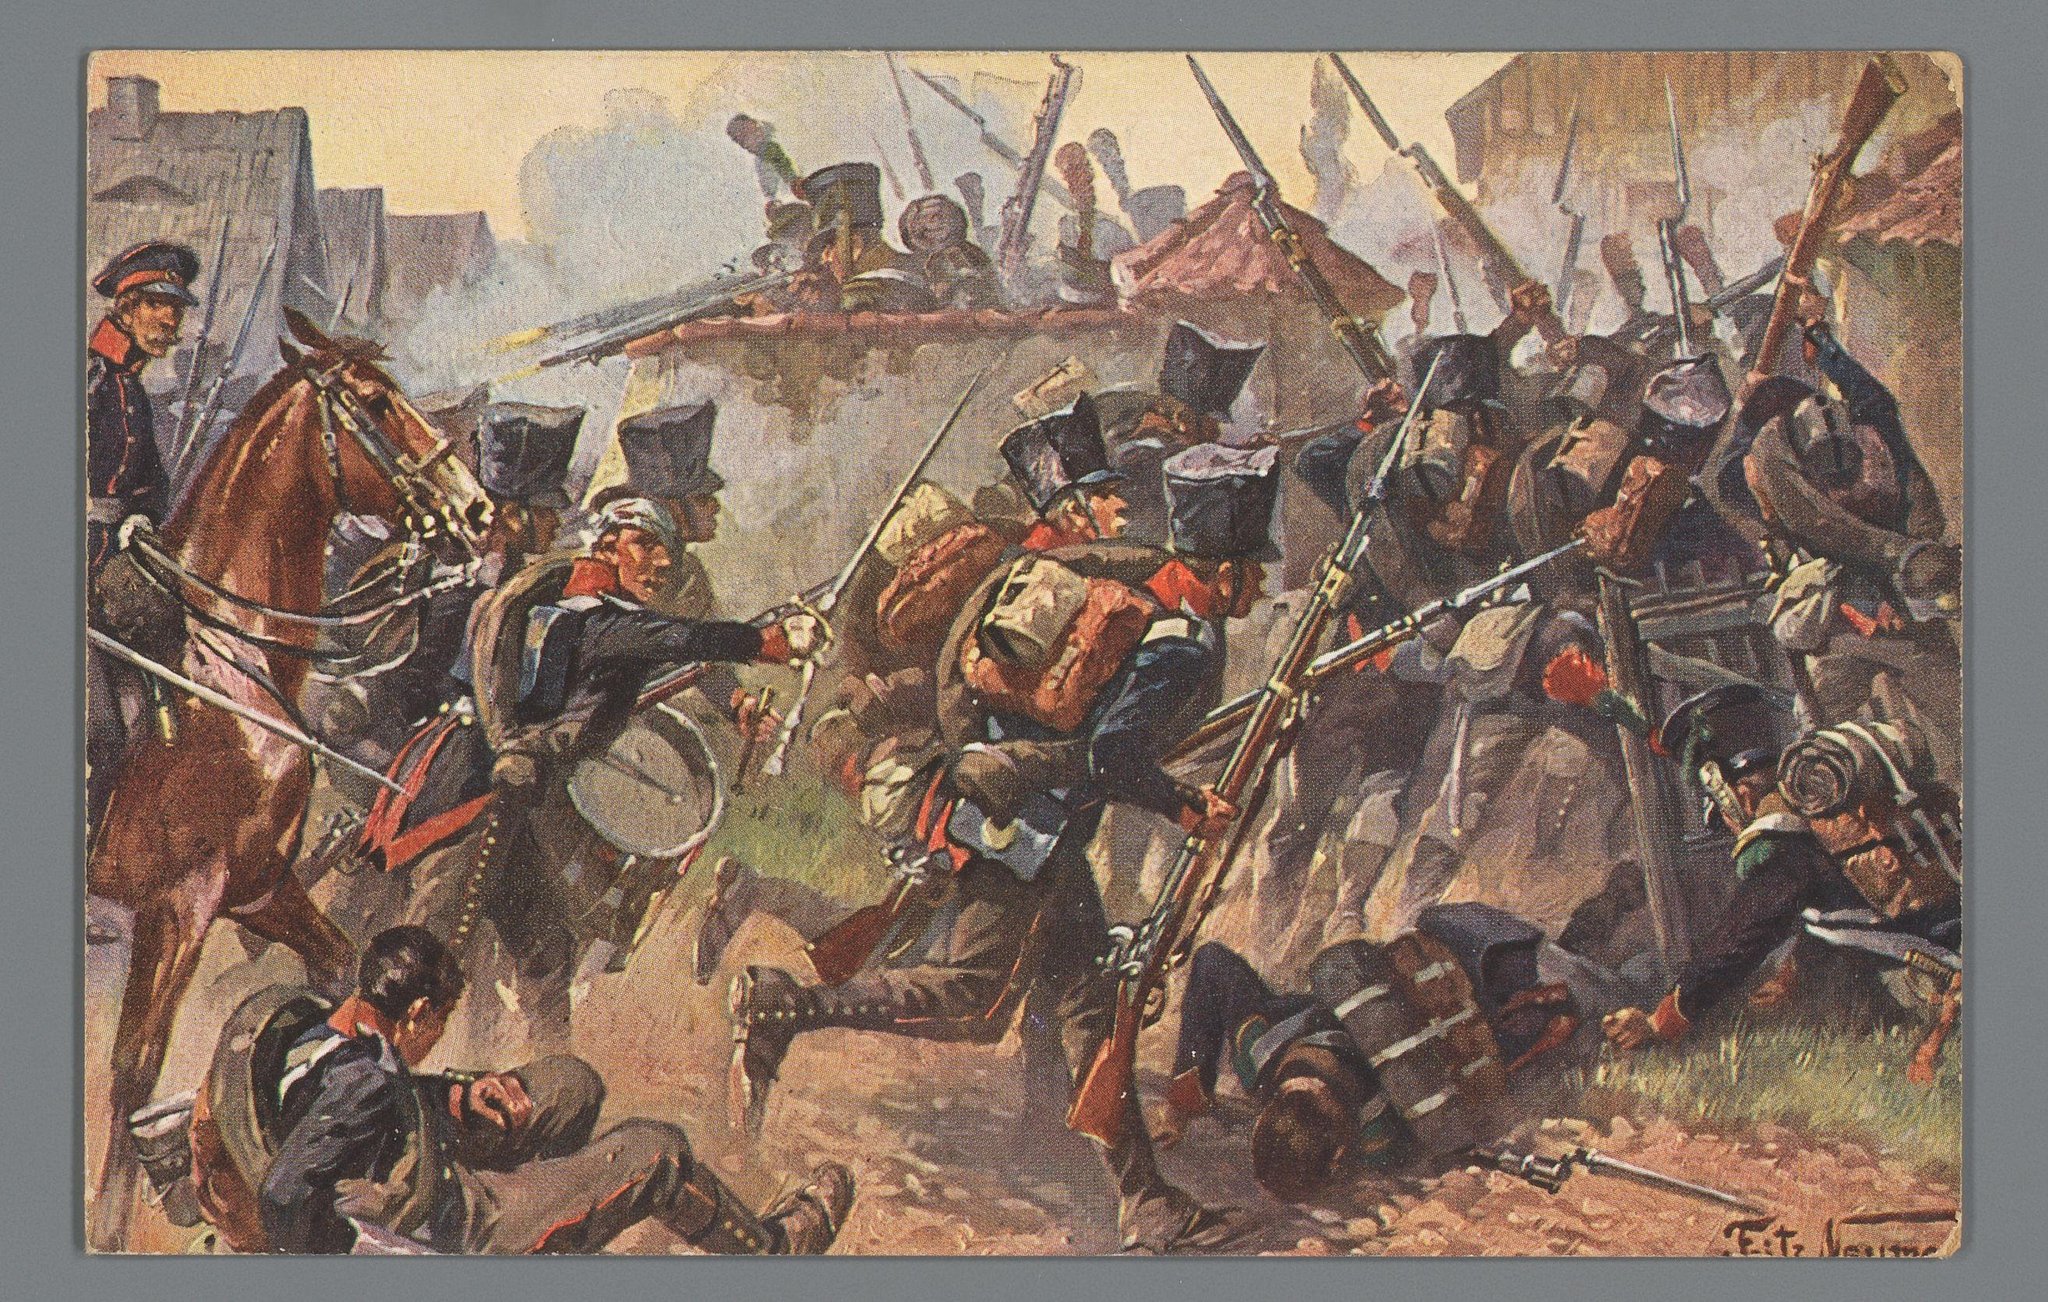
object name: photomechanical print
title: Gevecht tijdens de Slag bij Lützen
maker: fritz neumann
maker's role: printer, publisher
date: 1905-1920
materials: cardboard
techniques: three-color autotype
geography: germany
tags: battle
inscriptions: inscription: ‘Marke E.G.M.S. Serie 108.’, inscription: ‘68, oorlog’